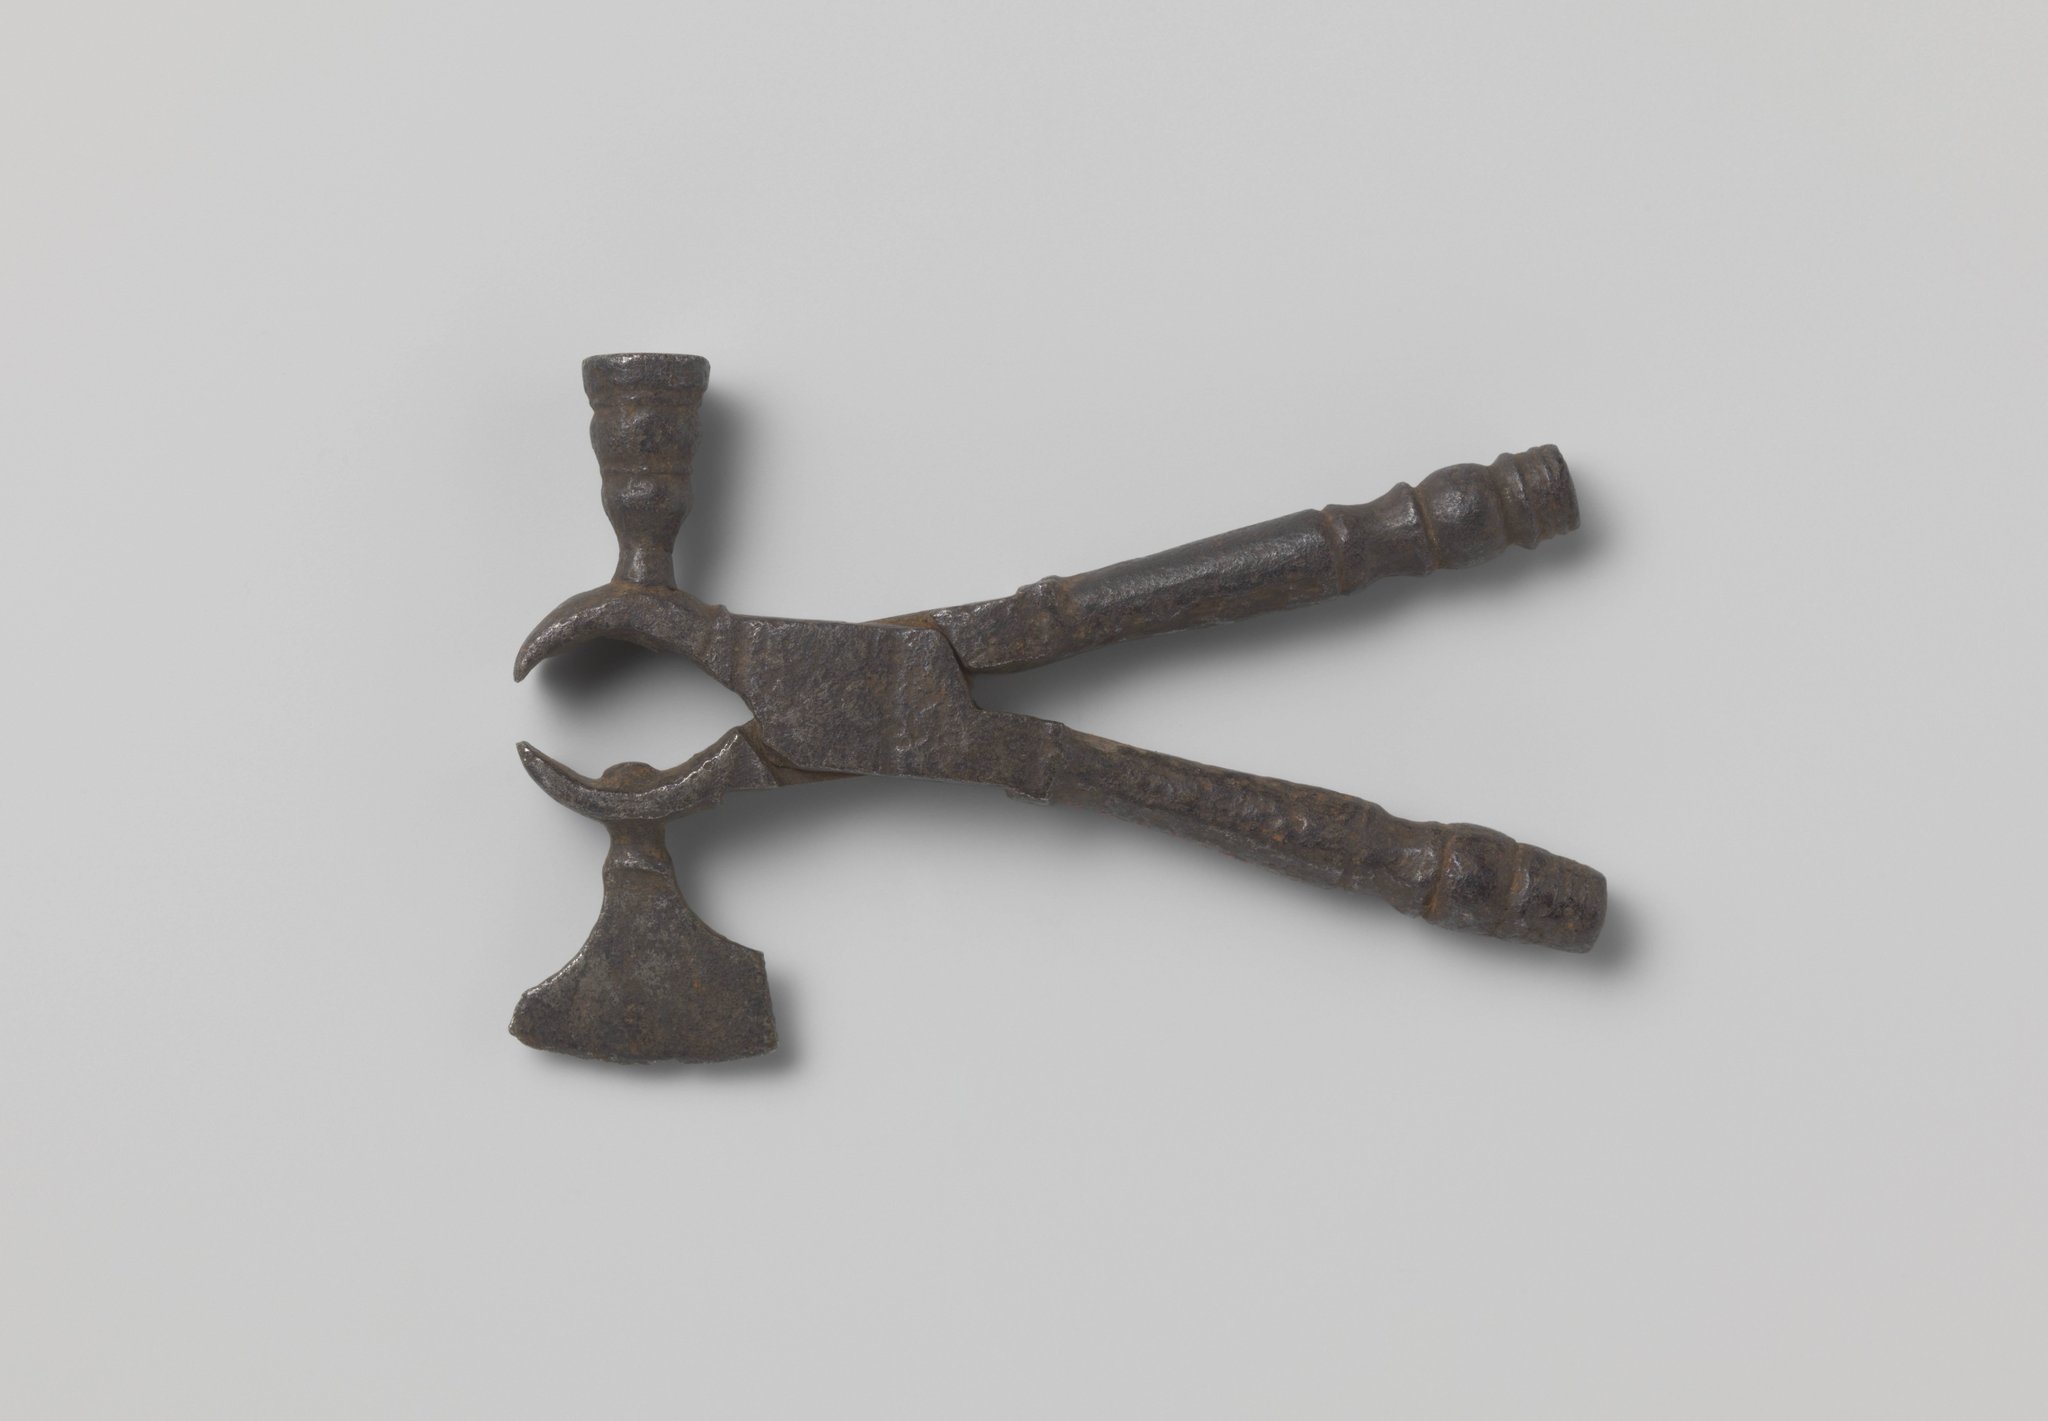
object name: nijptang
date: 1600-1699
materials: iron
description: Een kleine nijptang van ijzer, die tevens dienst kan doen als bijl en hamer. Afkomstig van verzameling E. Vita Israels.